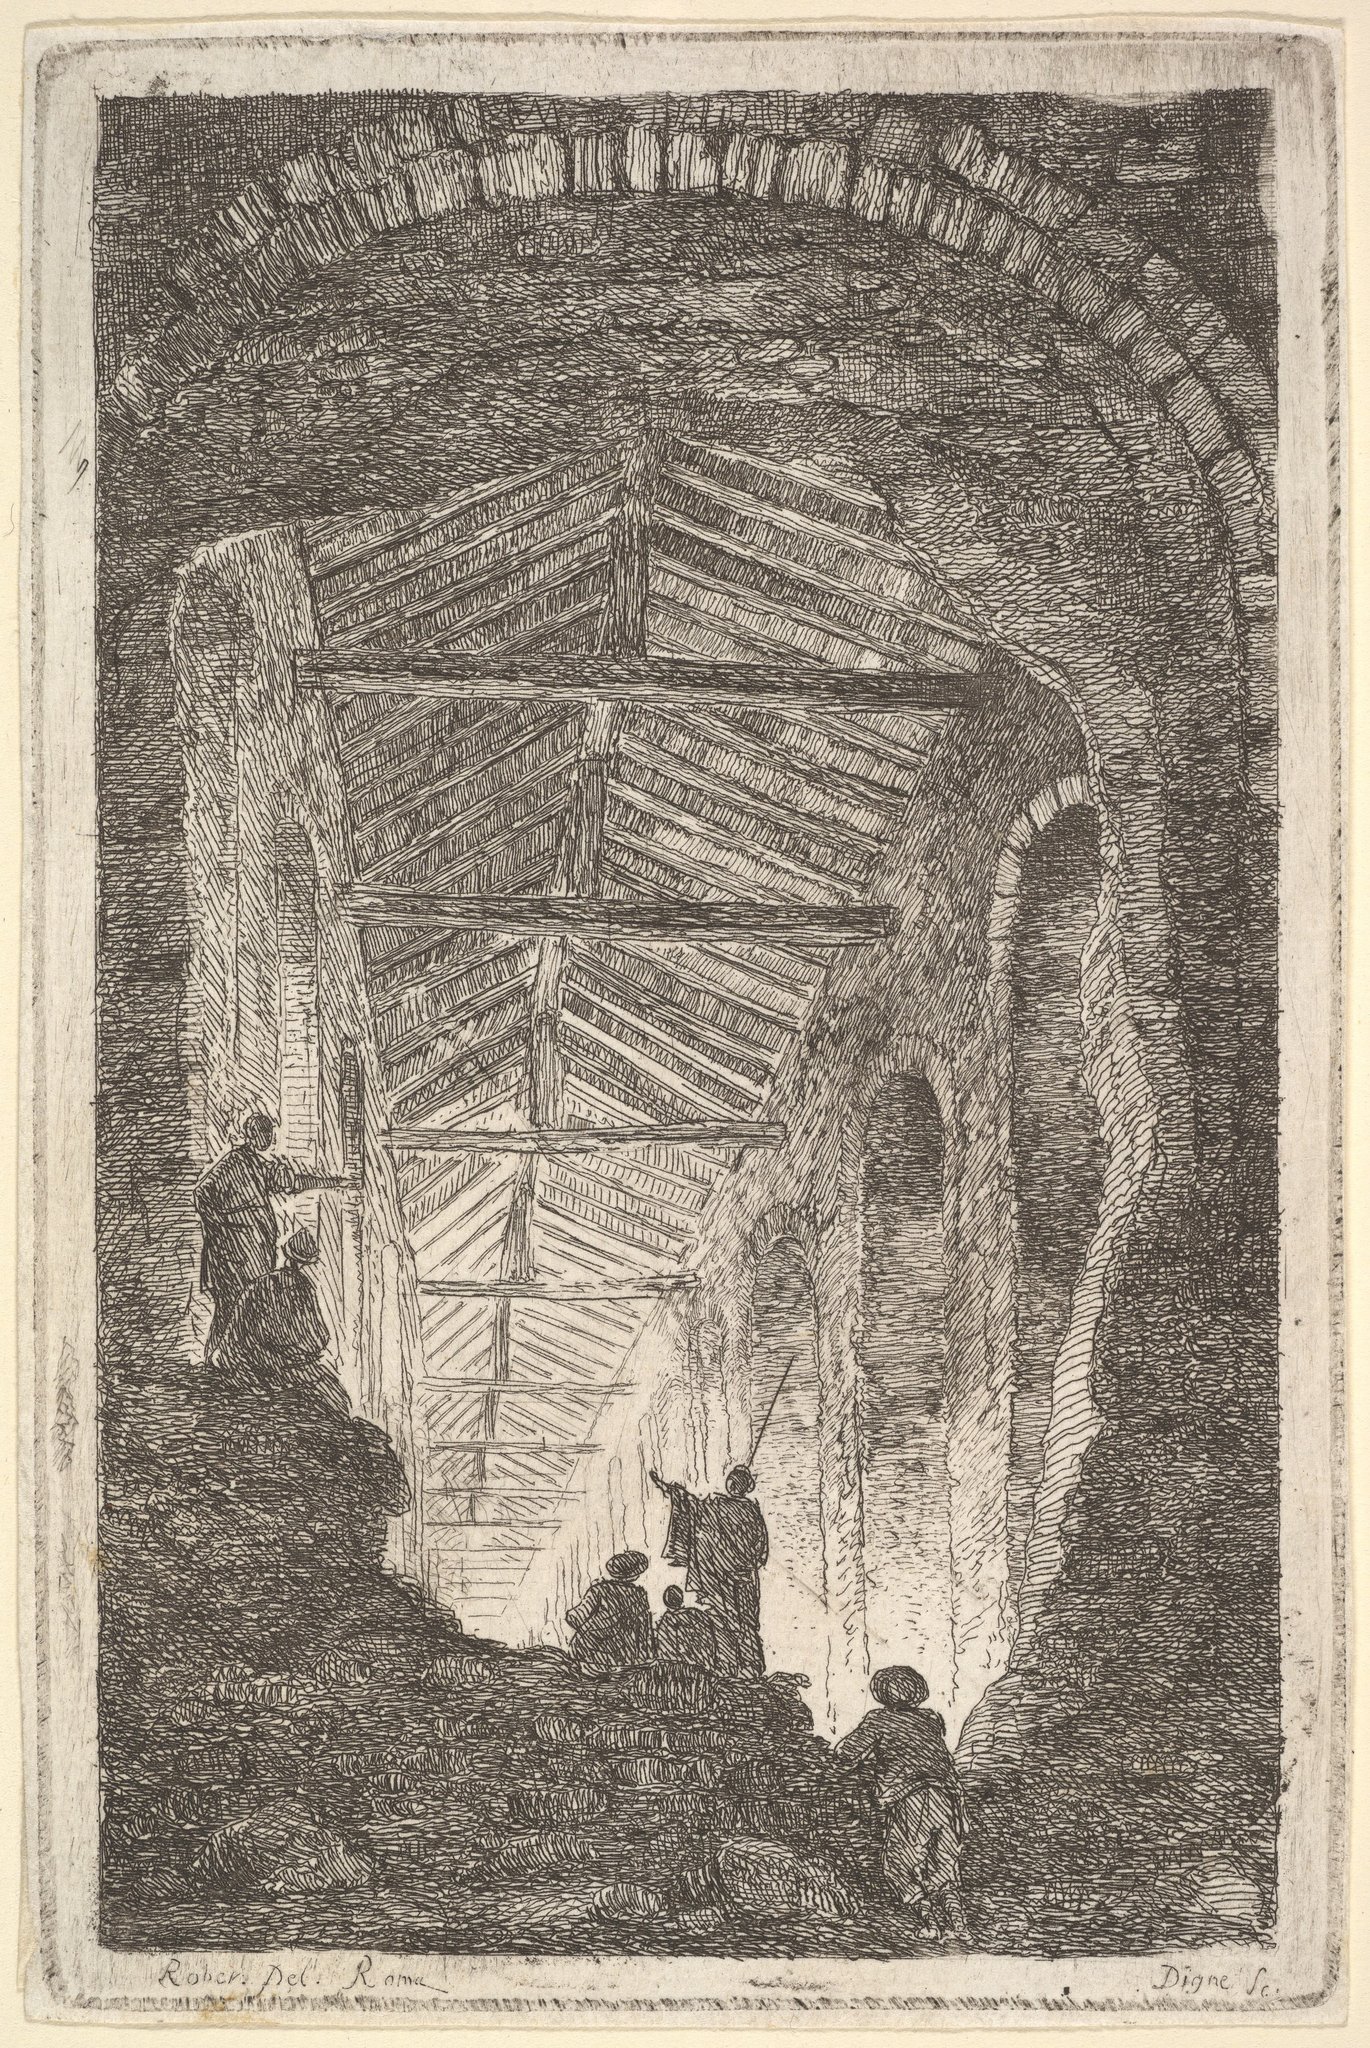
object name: print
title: Plate 10: The Ancient Gallery: a large covered gallery, light entering from the background, six figures standing atop piles of rocks in the foreground, from "Les soirées de Rome"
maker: hubert robert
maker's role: artist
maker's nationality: french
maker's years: 1733-1808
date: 1763-1764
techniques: etching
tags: human figures,architecture,buildings